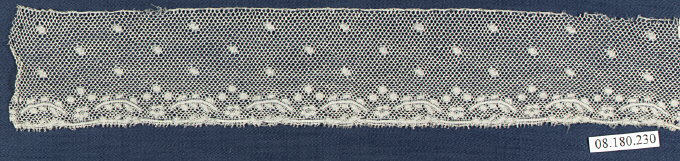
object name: fragment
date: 1767-1800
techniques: lace